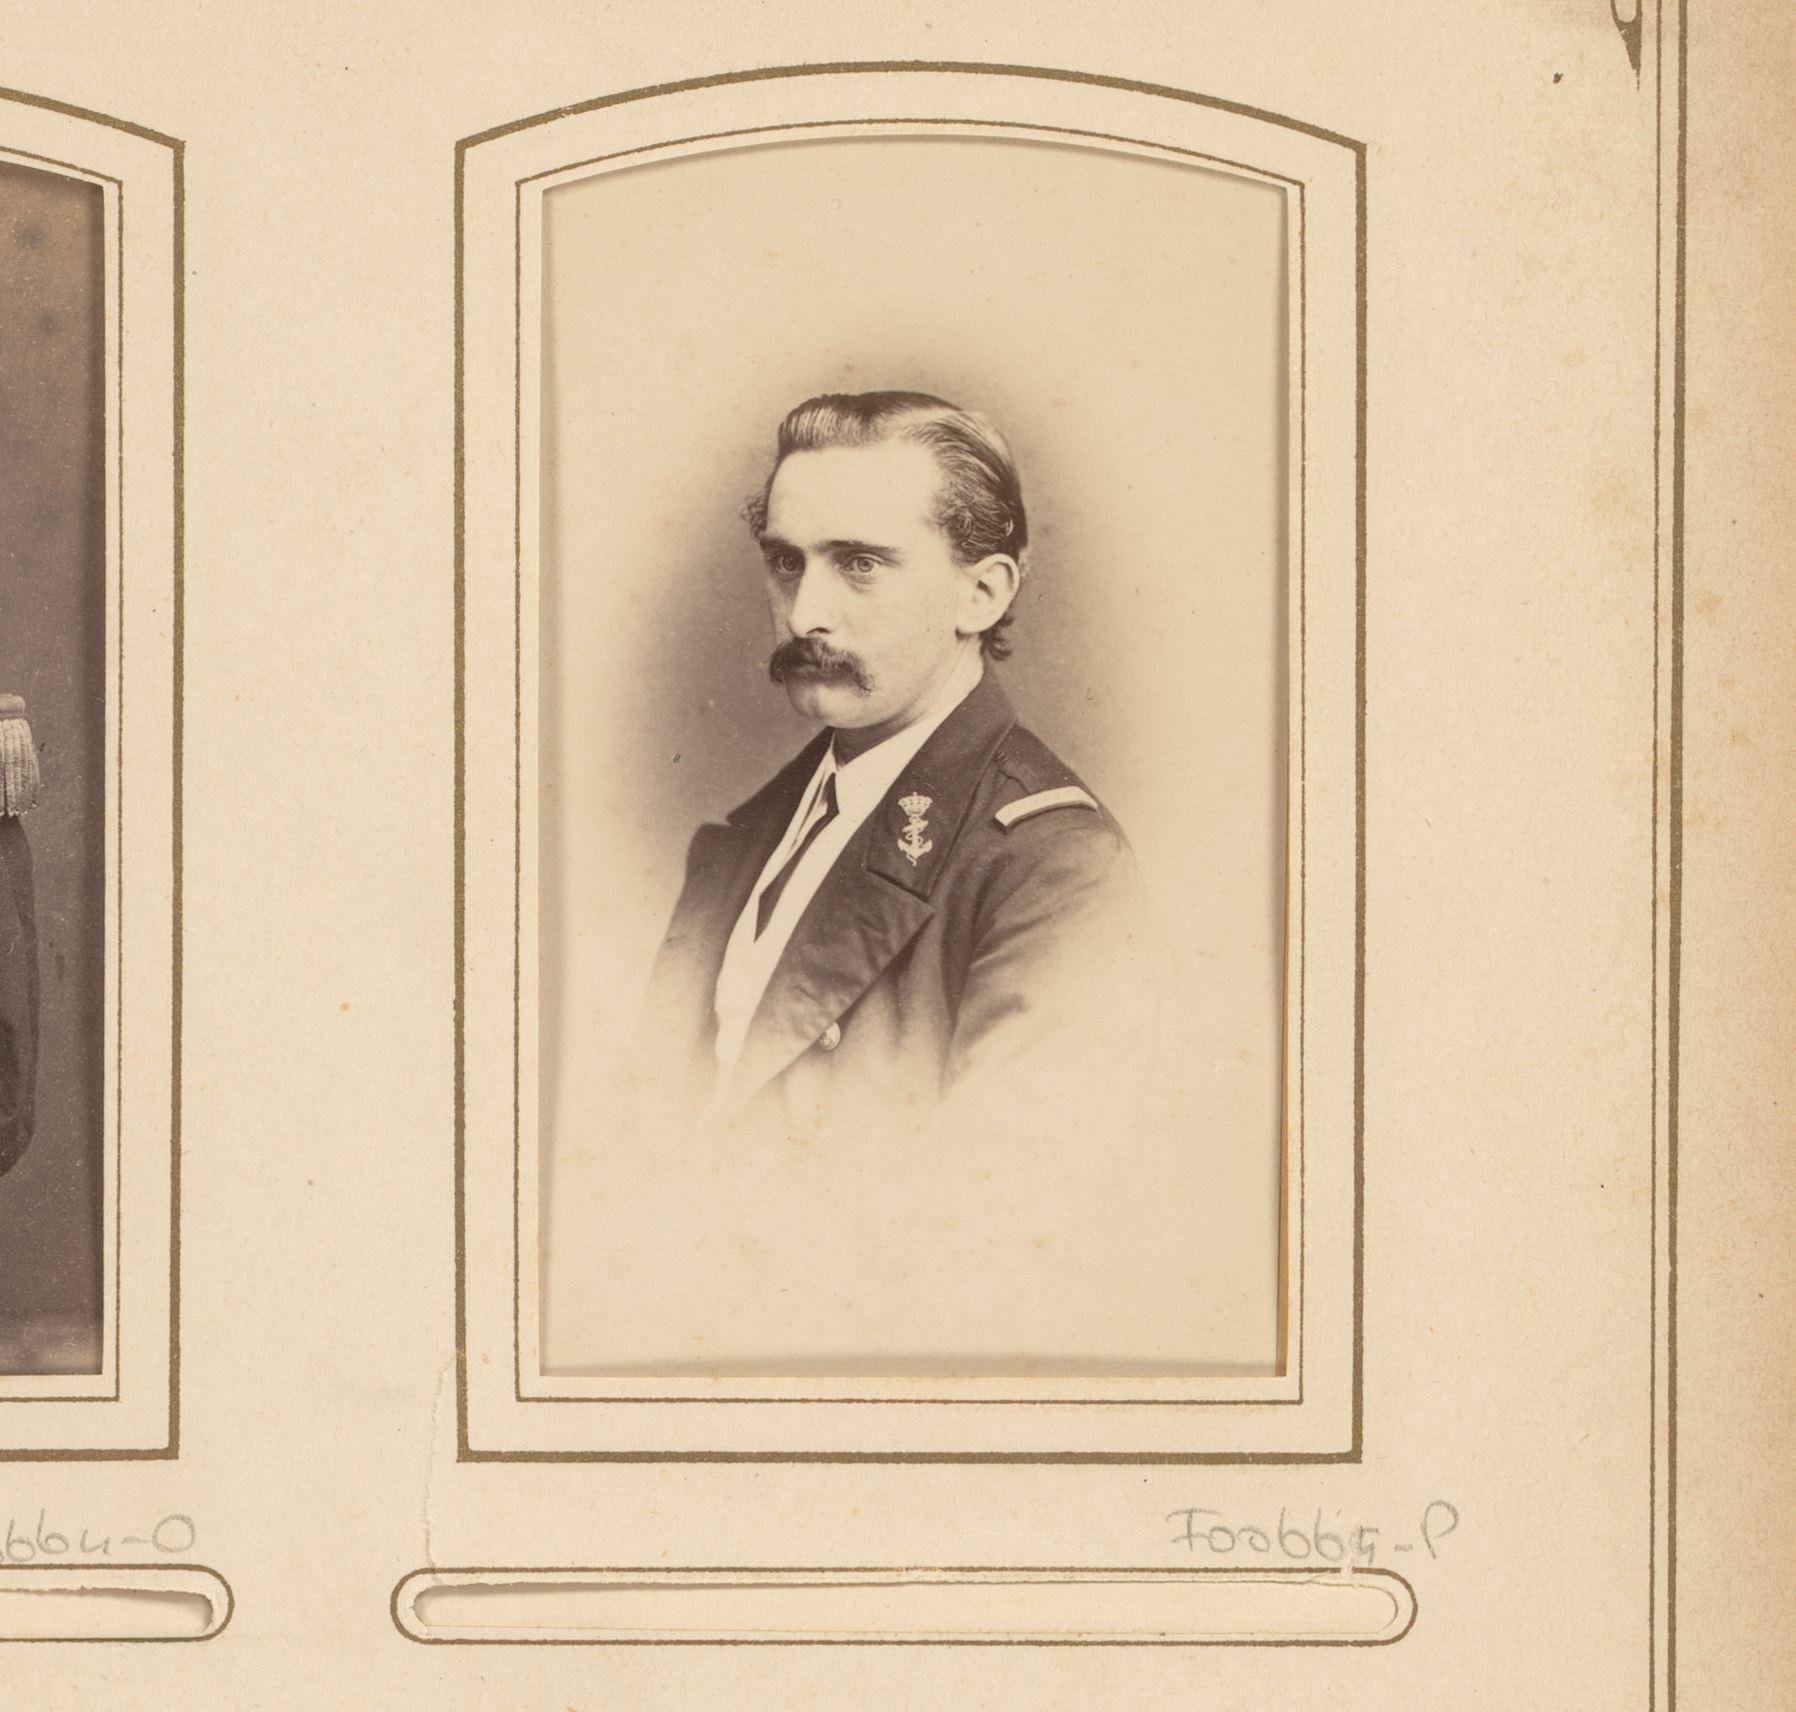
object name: carte de visite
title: Portret van een man met insigne op jas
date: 1860-1880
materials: cardboard, photographic support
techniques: albumen print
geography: batavia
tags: historical persons, insignia of companies, etc.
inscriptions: inscription: ‘Woodbury & Page/ Photographers/ Java’